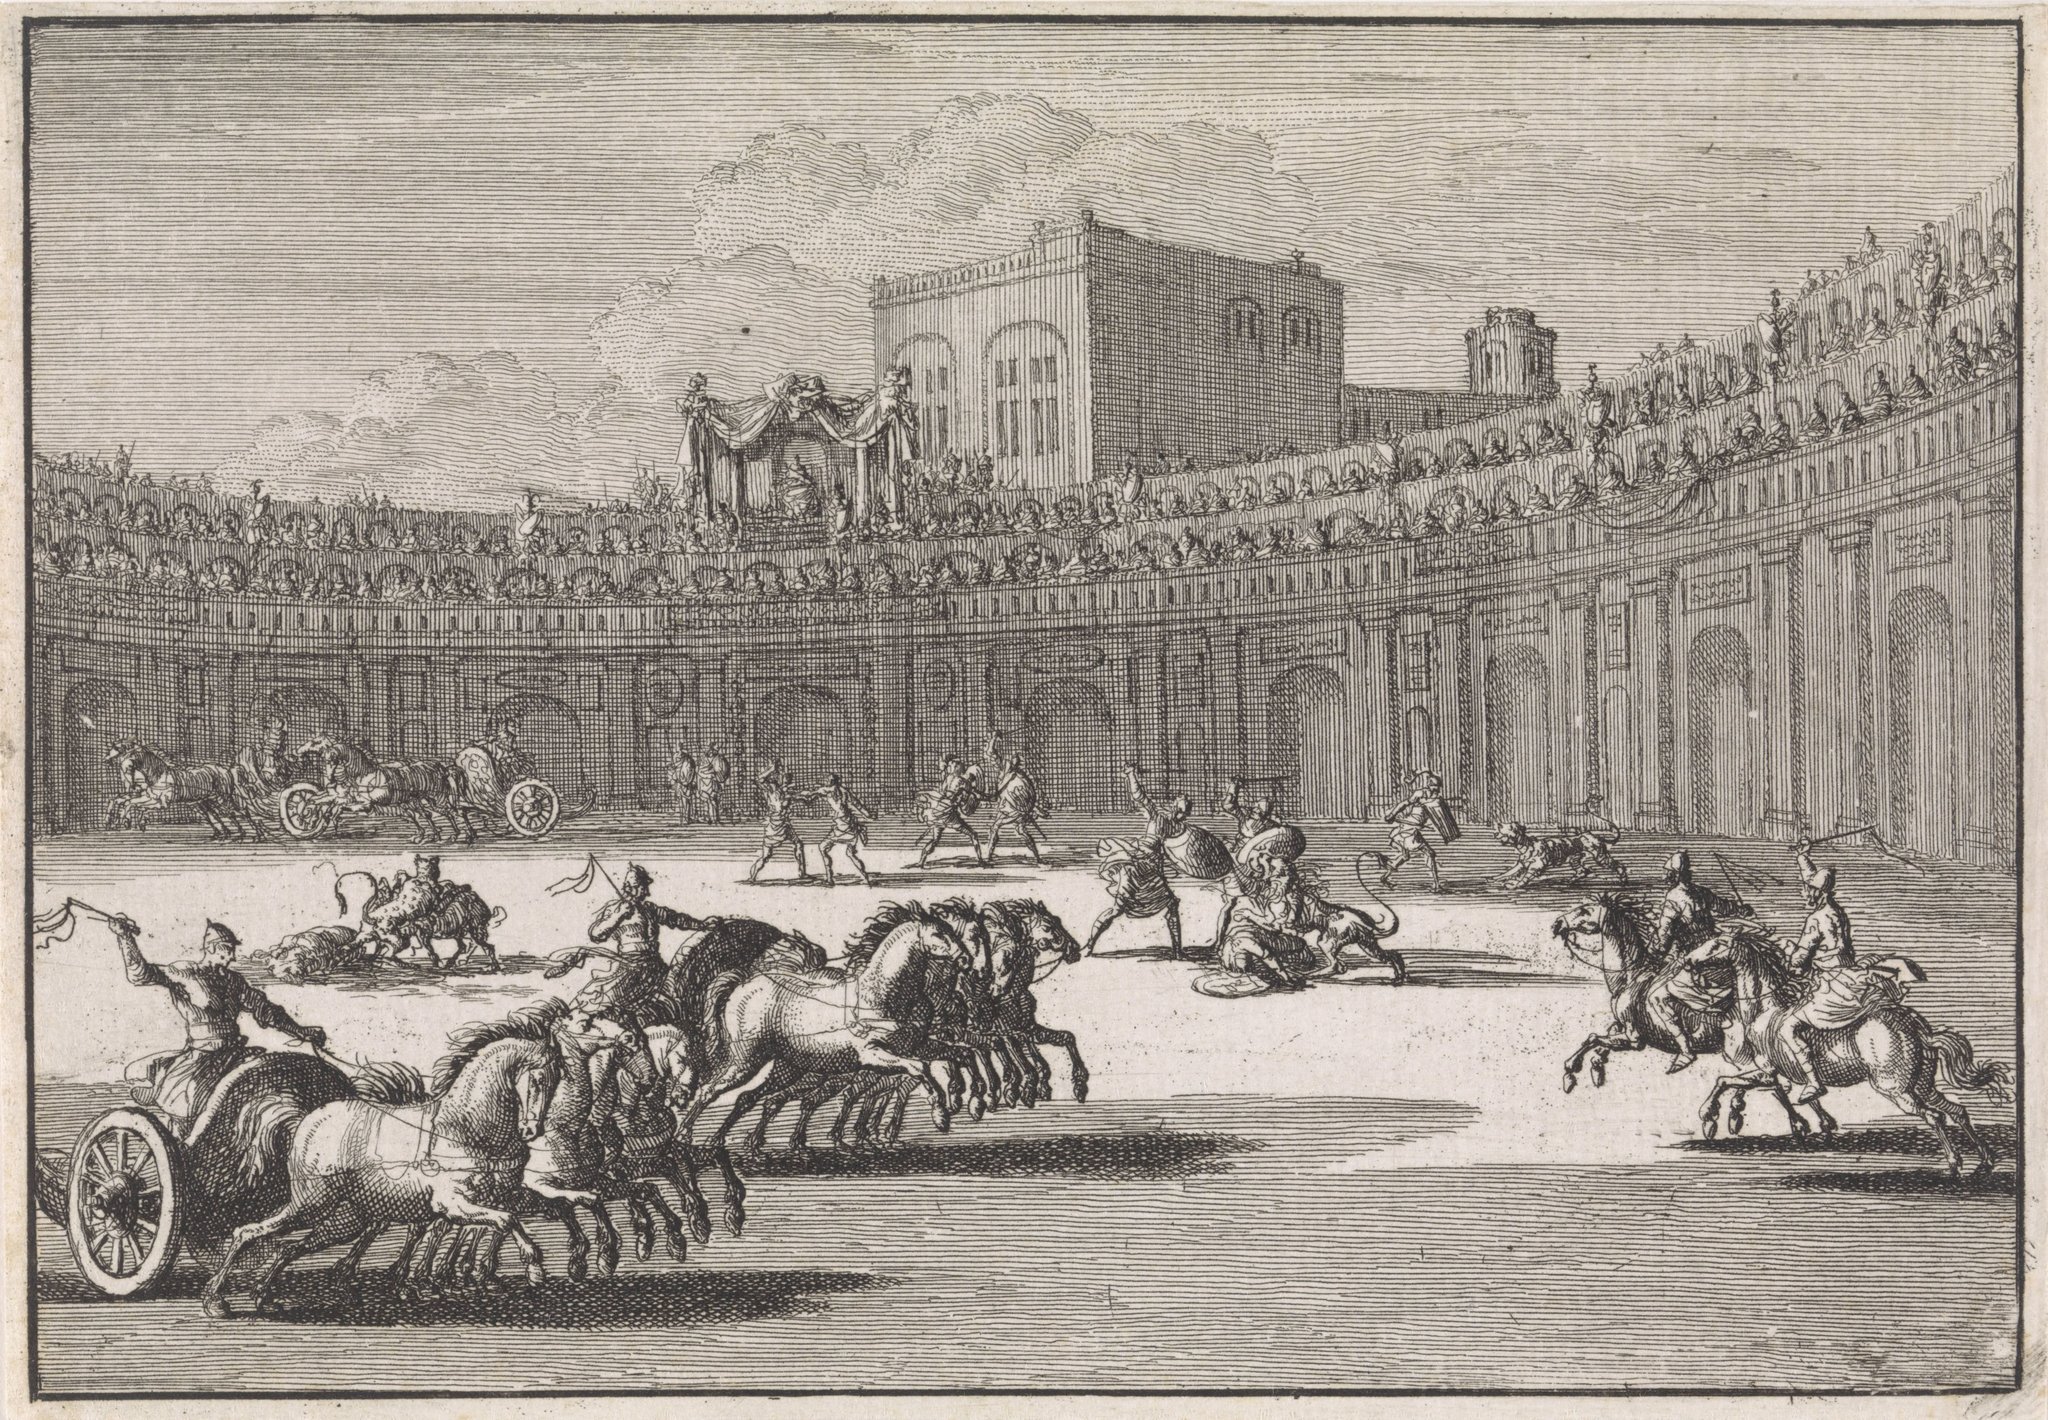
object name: print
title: Renspelen te Jeruzalem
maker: jan luyken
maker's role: draughtsman, print maker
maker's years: 1649-1712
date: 1704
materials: paper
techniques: etching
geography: amsterdam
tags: wagon racing with two-wheeled vehicle, e.g.: chariot, sulky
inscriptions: collector's mark: Lugt 2228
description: Prent ook gebruikt als boekillustratie in: Josephus, Flavius. Alle de Werken, 2 delen. Amsterdam: Pieter Mortier, 1704, dl. 1, p. 375.